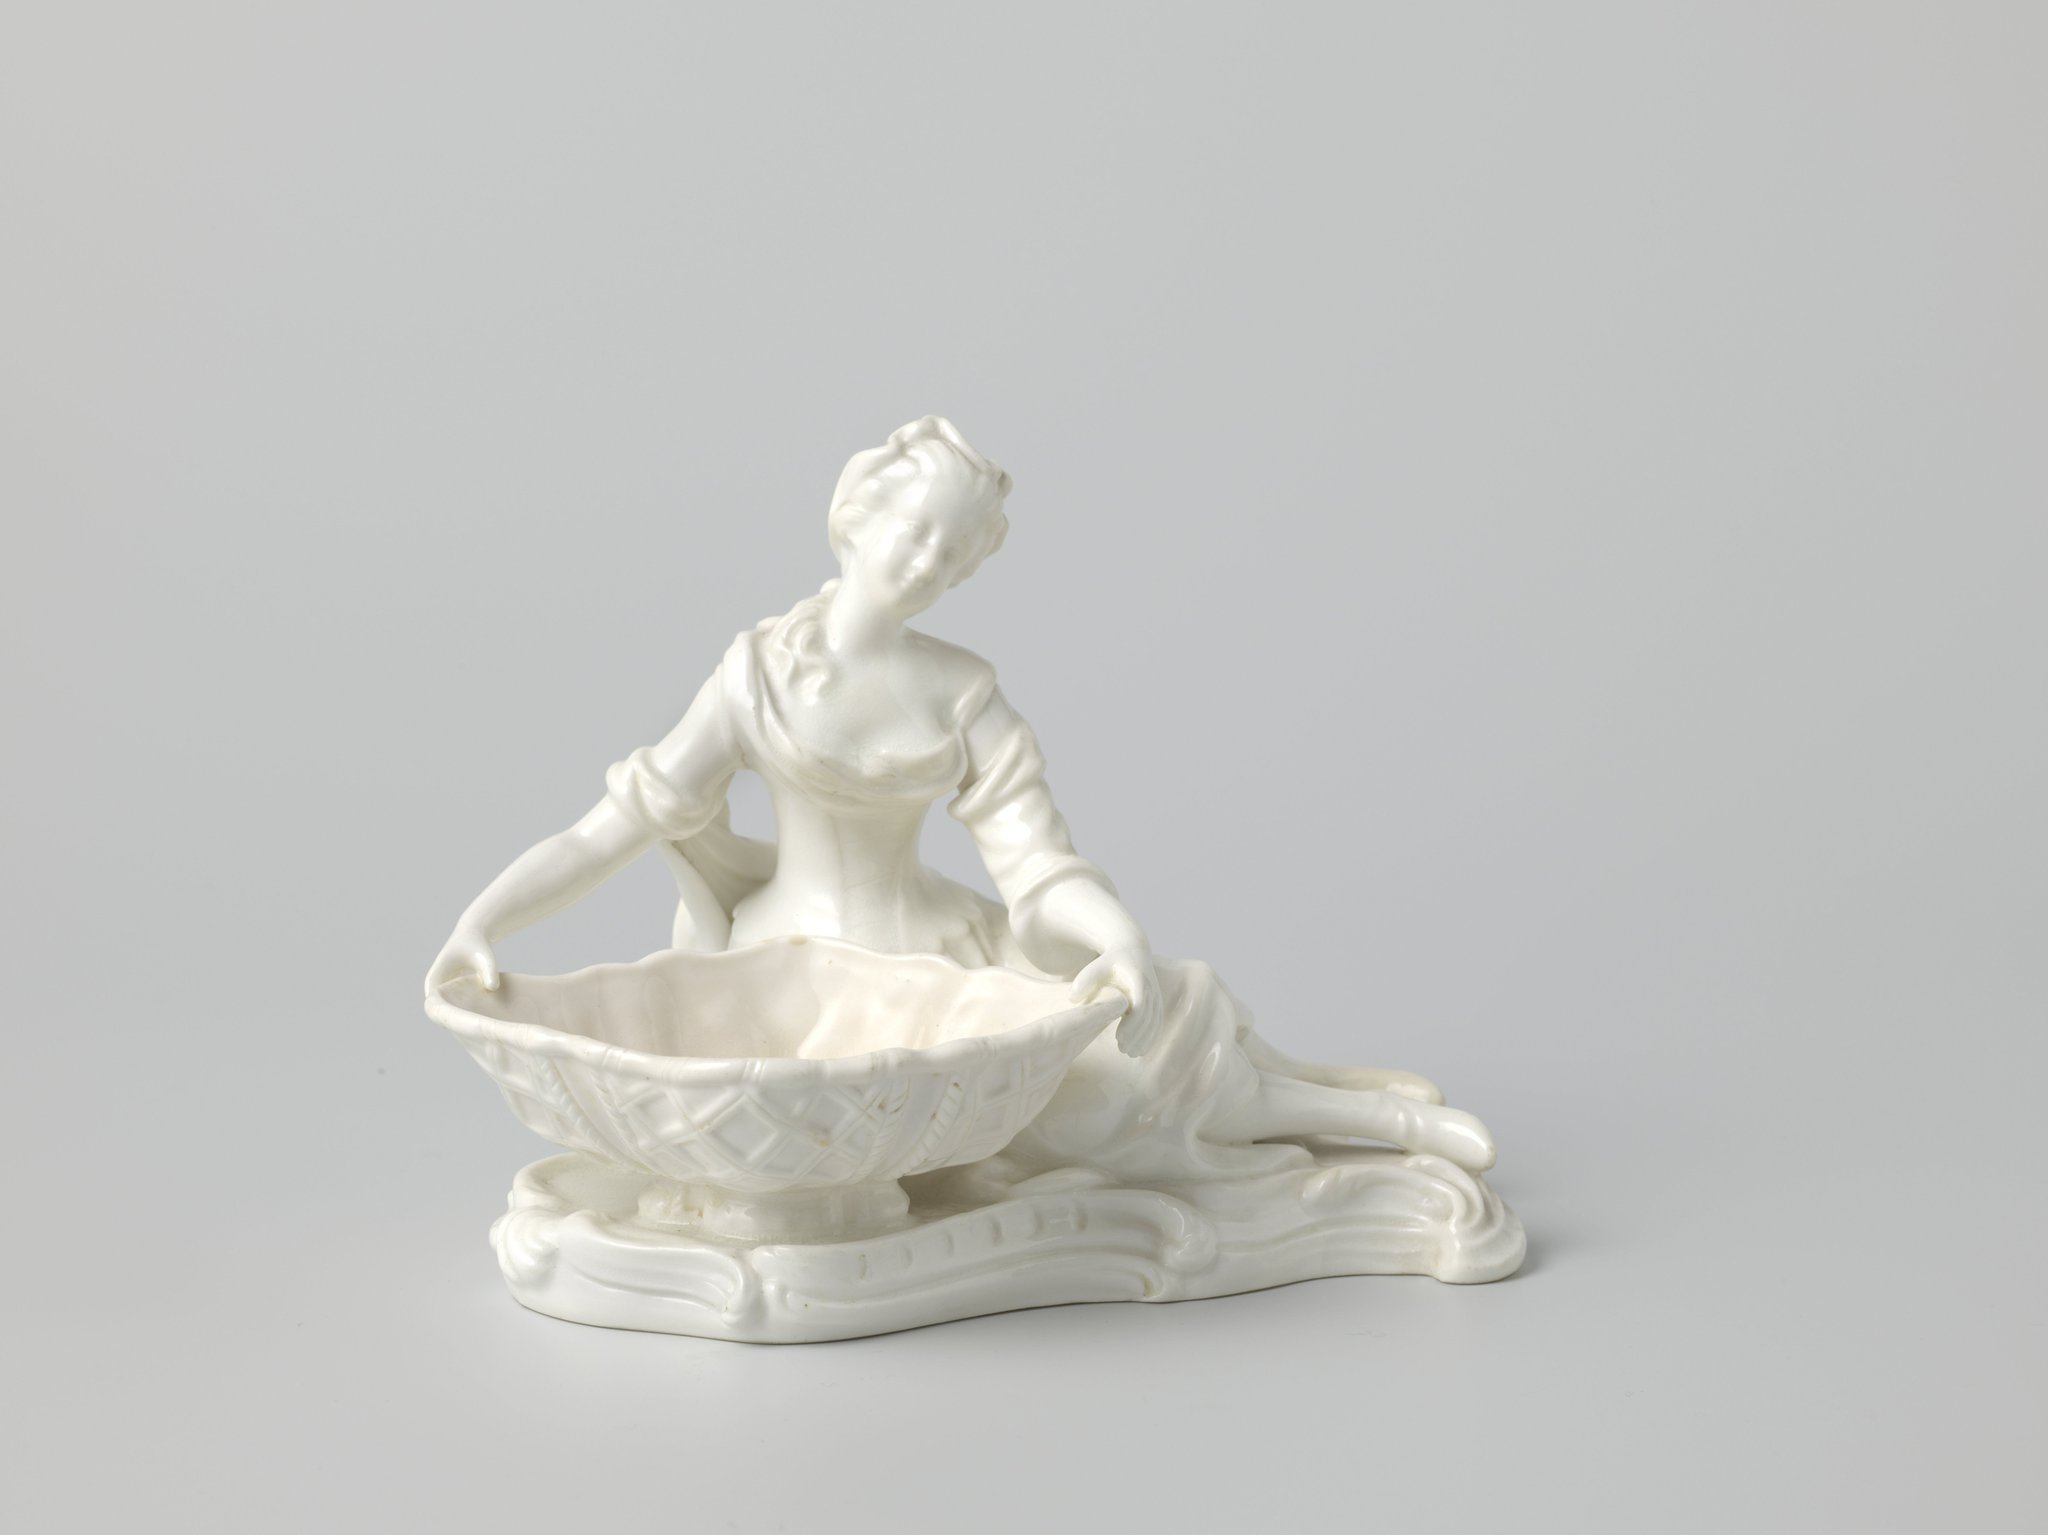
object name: container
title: Bak, door een halfliggende vrouwenfiguur met beide armen vastgehouden.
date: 1840-1860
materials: porcelain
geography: stoke-on-trent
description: Bak van wit porselein:figuur van een vrouw in achttiende-eeuws kostuum, in halfliggende houding, met beide armen een bak voor zich uit houdend. Het voetstuk is met rocailles versierd. Gemerkt: MINTON MB 56 1.1